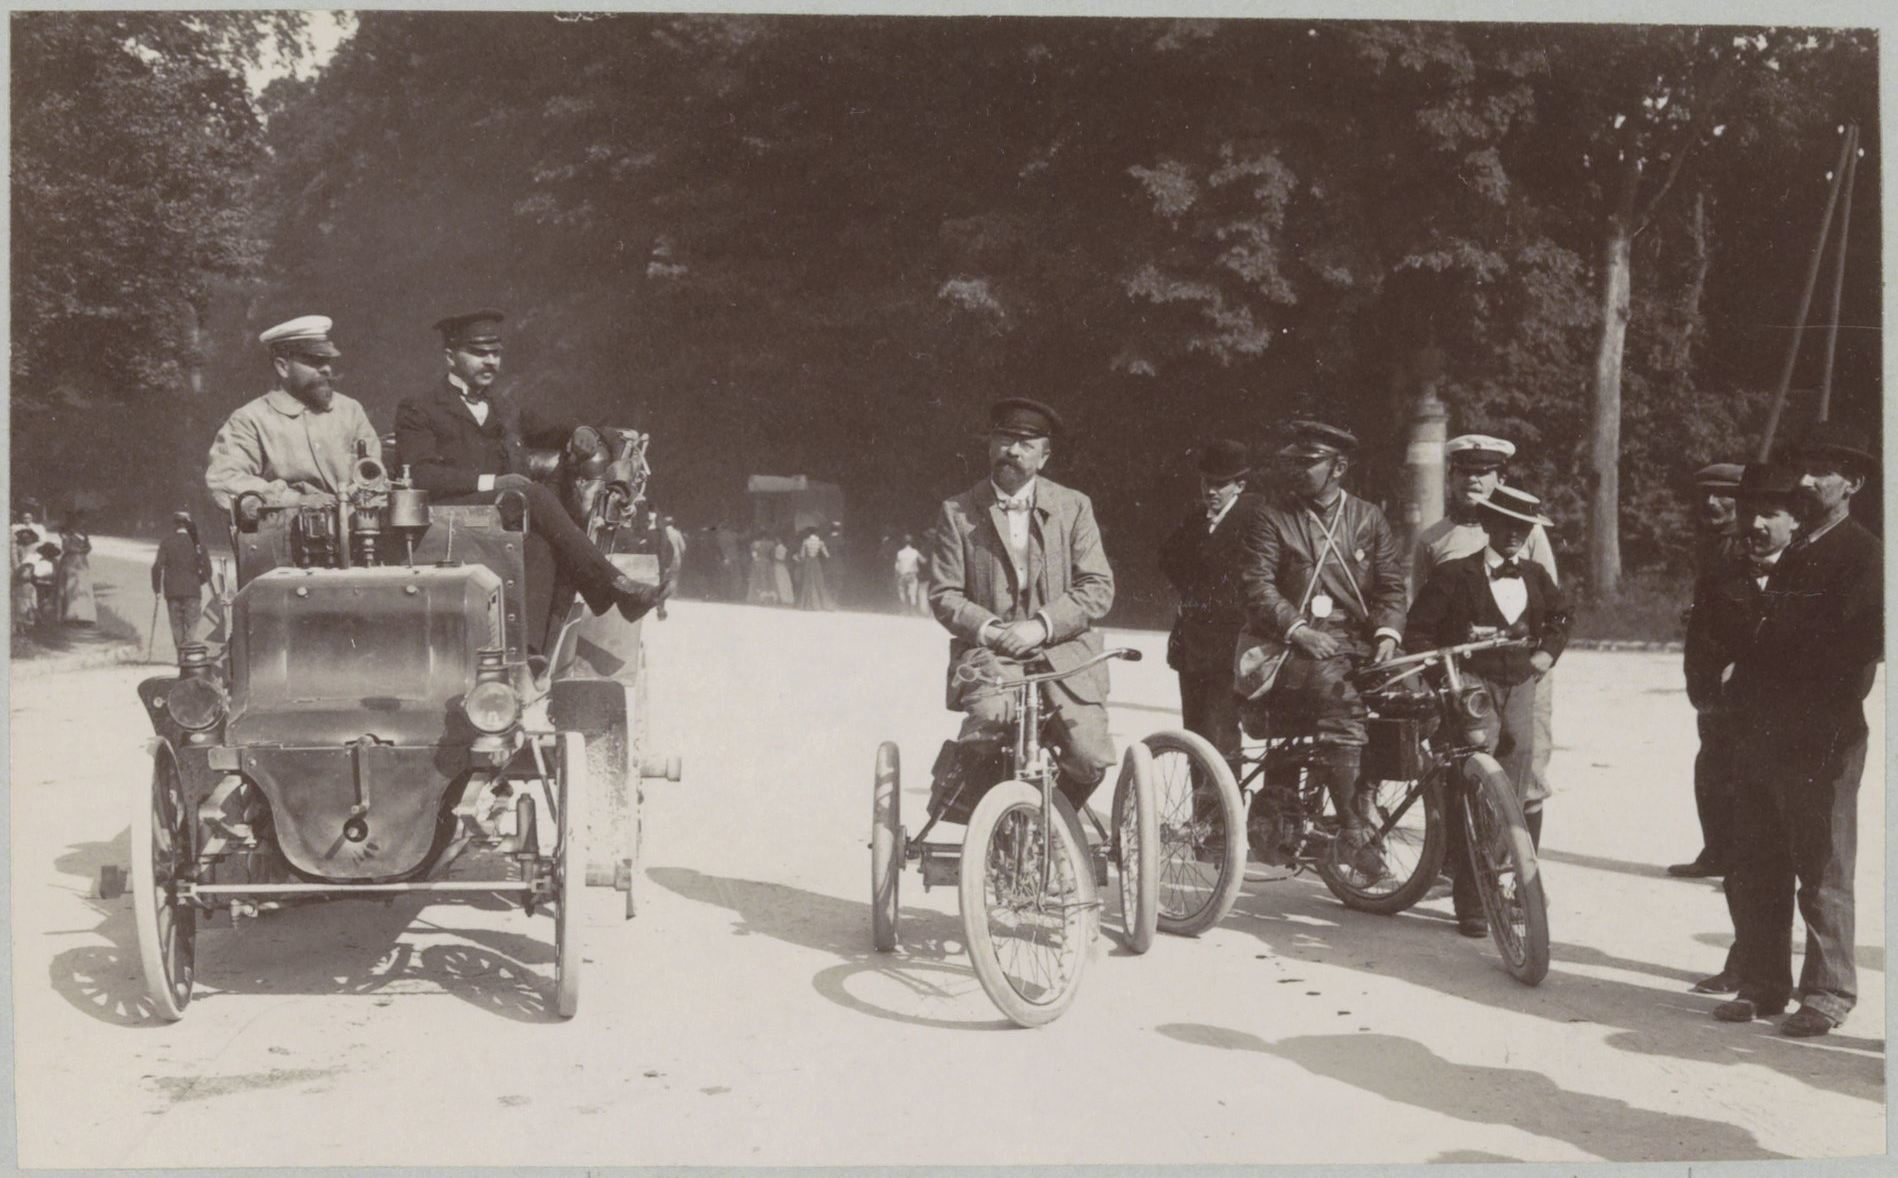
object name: photograph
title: Deelnemers aan een rallye in Fontainebleau: een automobiel en twee gemotoriseerde driewielers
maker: delizy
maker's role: manufacturer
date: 1899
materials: paper, photographic support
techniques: albumen print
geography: fontainebleau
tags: motor-cycles and other two-wheeled motor-vehicles, automobile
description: Onderdeel van Fotoalbum van een Franse amateurfotograaf met opnames van uitstapjes in Frankrijk, Spanje, België, Luxemburg en Nederland, de eerste automobielen en autoraces.